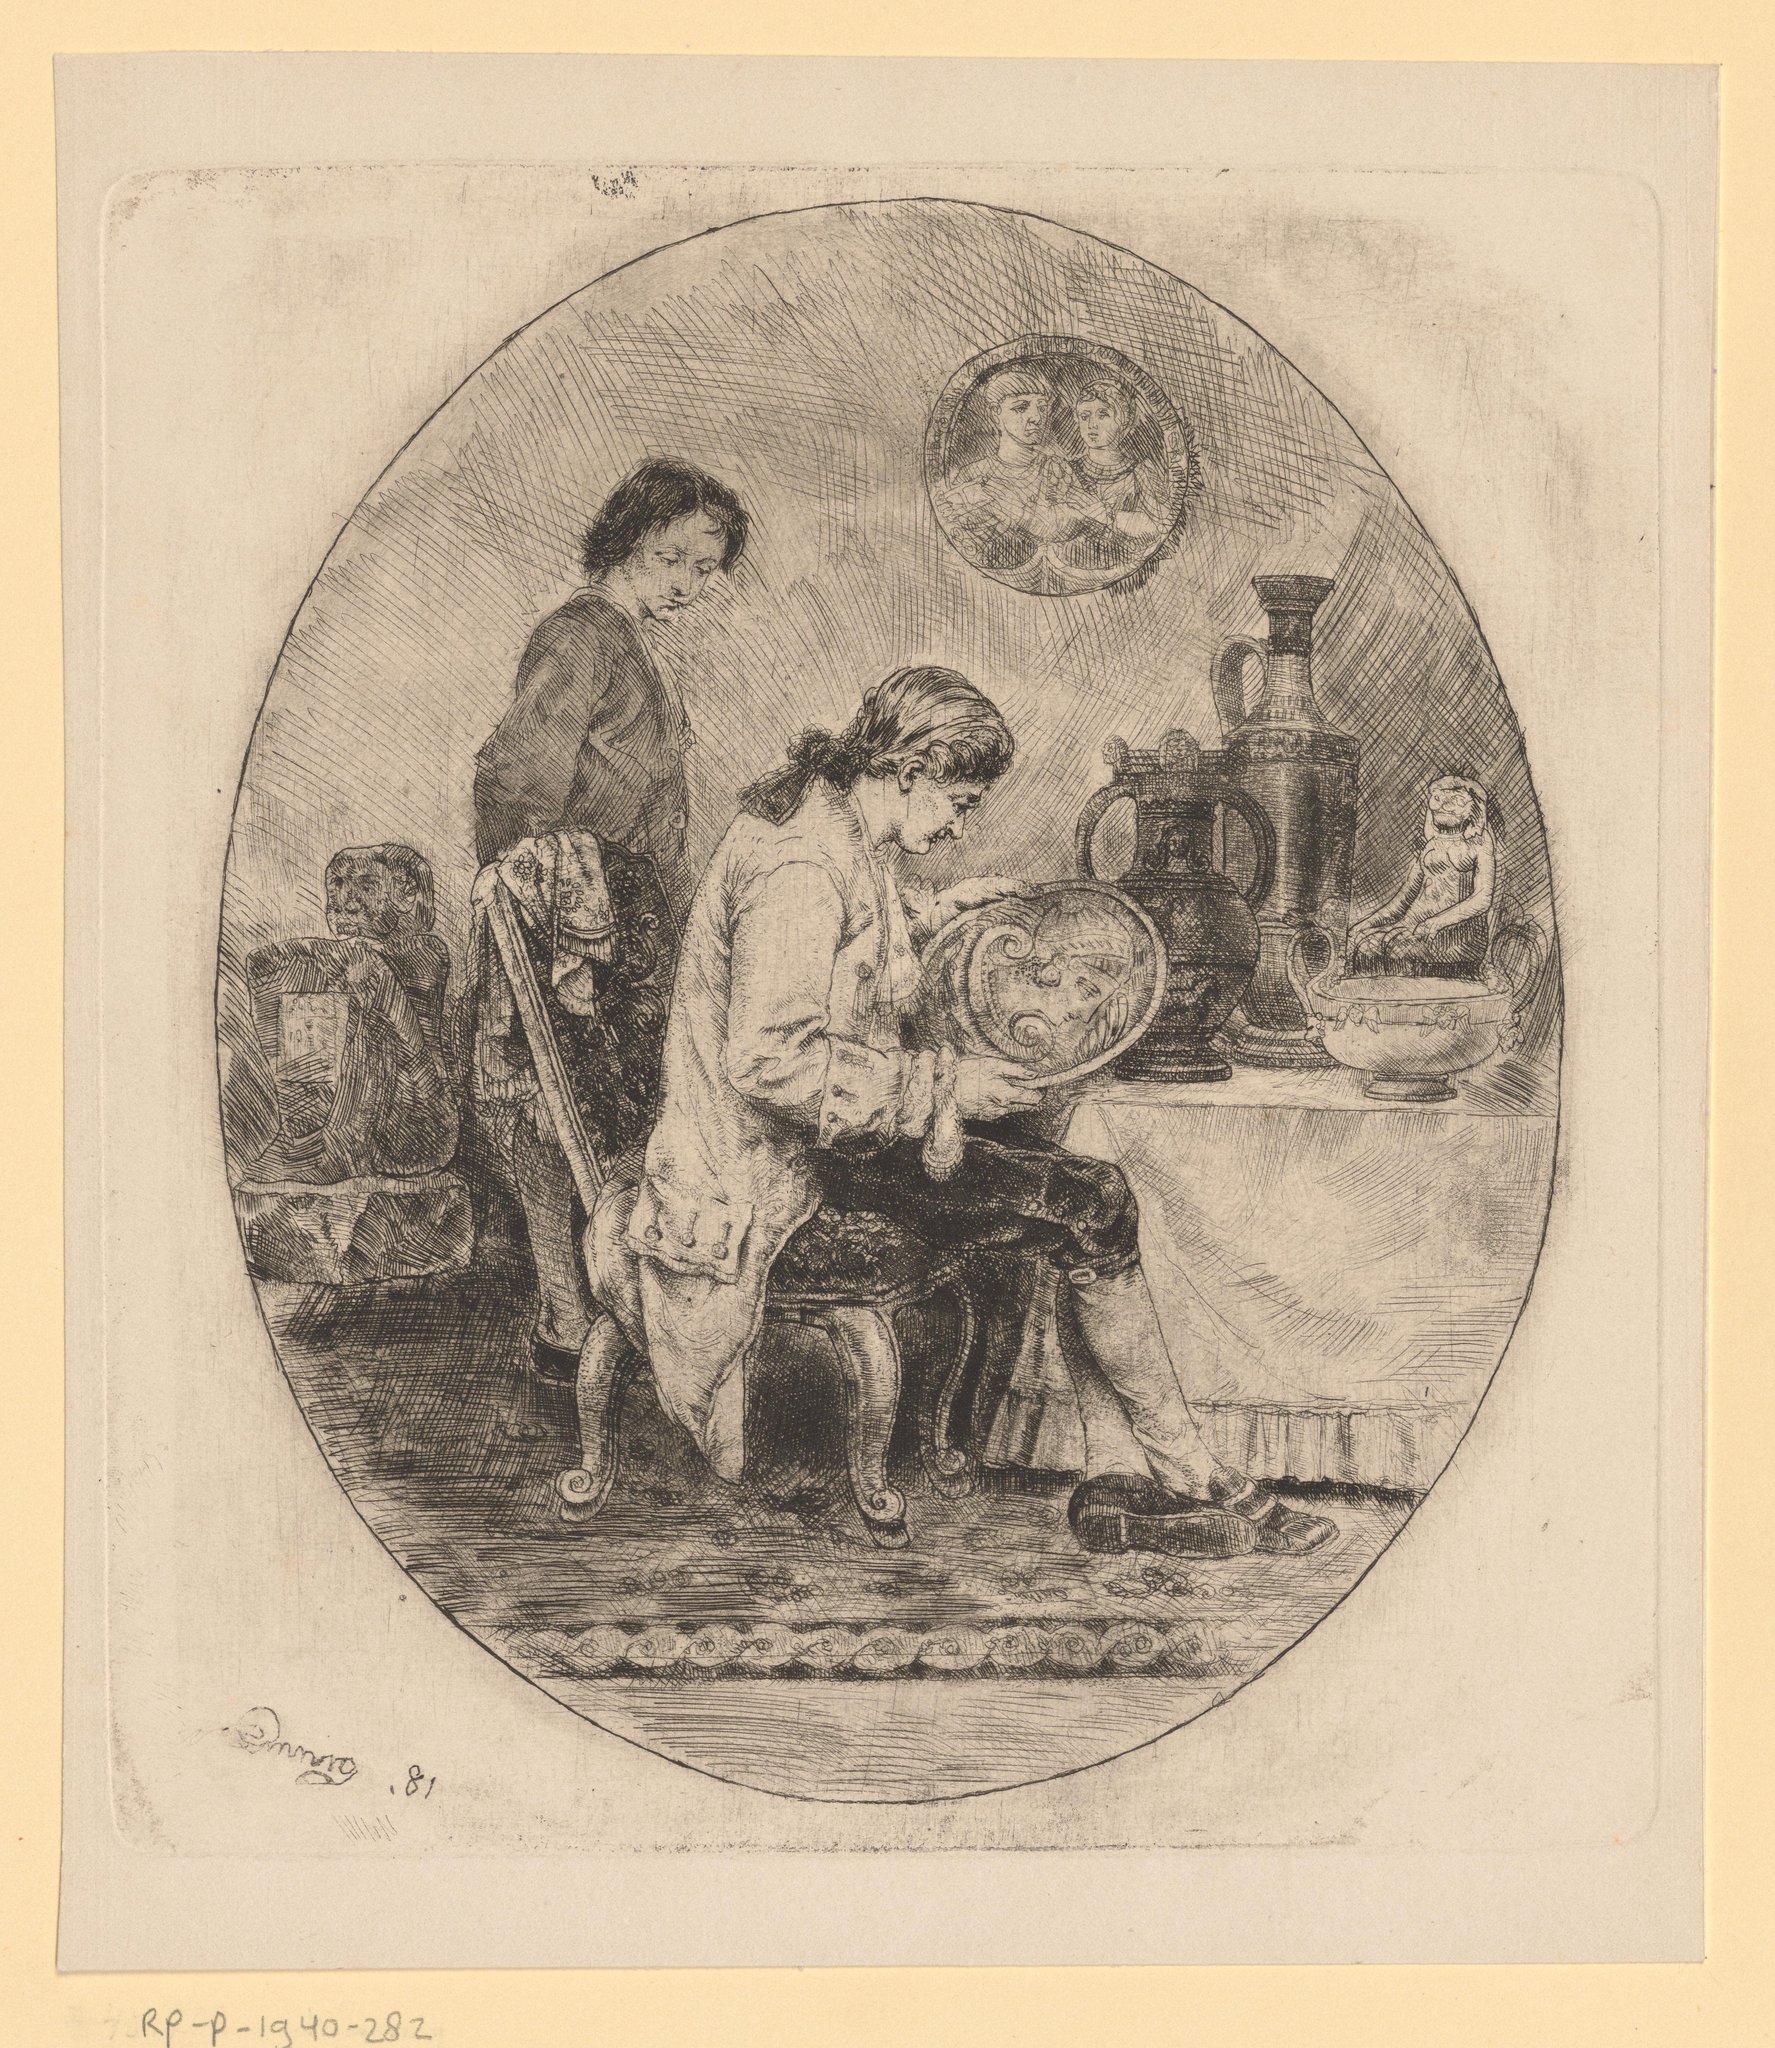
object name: print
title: Zelfportret aan tafel met antieke voorwerpen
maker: willem linnig (ii)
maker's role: print maker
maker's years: 1842-1890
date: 1881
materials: paper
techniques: etching, intaglio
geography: antwerp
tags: antwerp, print maker, willem linnig (ii), historical persons, art collector, father and son(s) (family group), container of stone: stone vase, chair, portrait, self-portrait of graphic artist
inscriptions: collector's mark: Lugt 2760, inscription: ‘De staande figuur is het portret/ van zijn zoon Benjamin’, inscription: ‘W. Linnig de oude of de Jonge?’, collector's mark: Lugt 2228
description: Volgens Van Someren gaat het hier om een portret van Willem Linnig (I), samen met zijn zoon Benjamin (1860-1929). Gezien de leeftijd van de geportretteerde is het echter waarschijnlijk dat het een portret is van Willem Linnig (II).